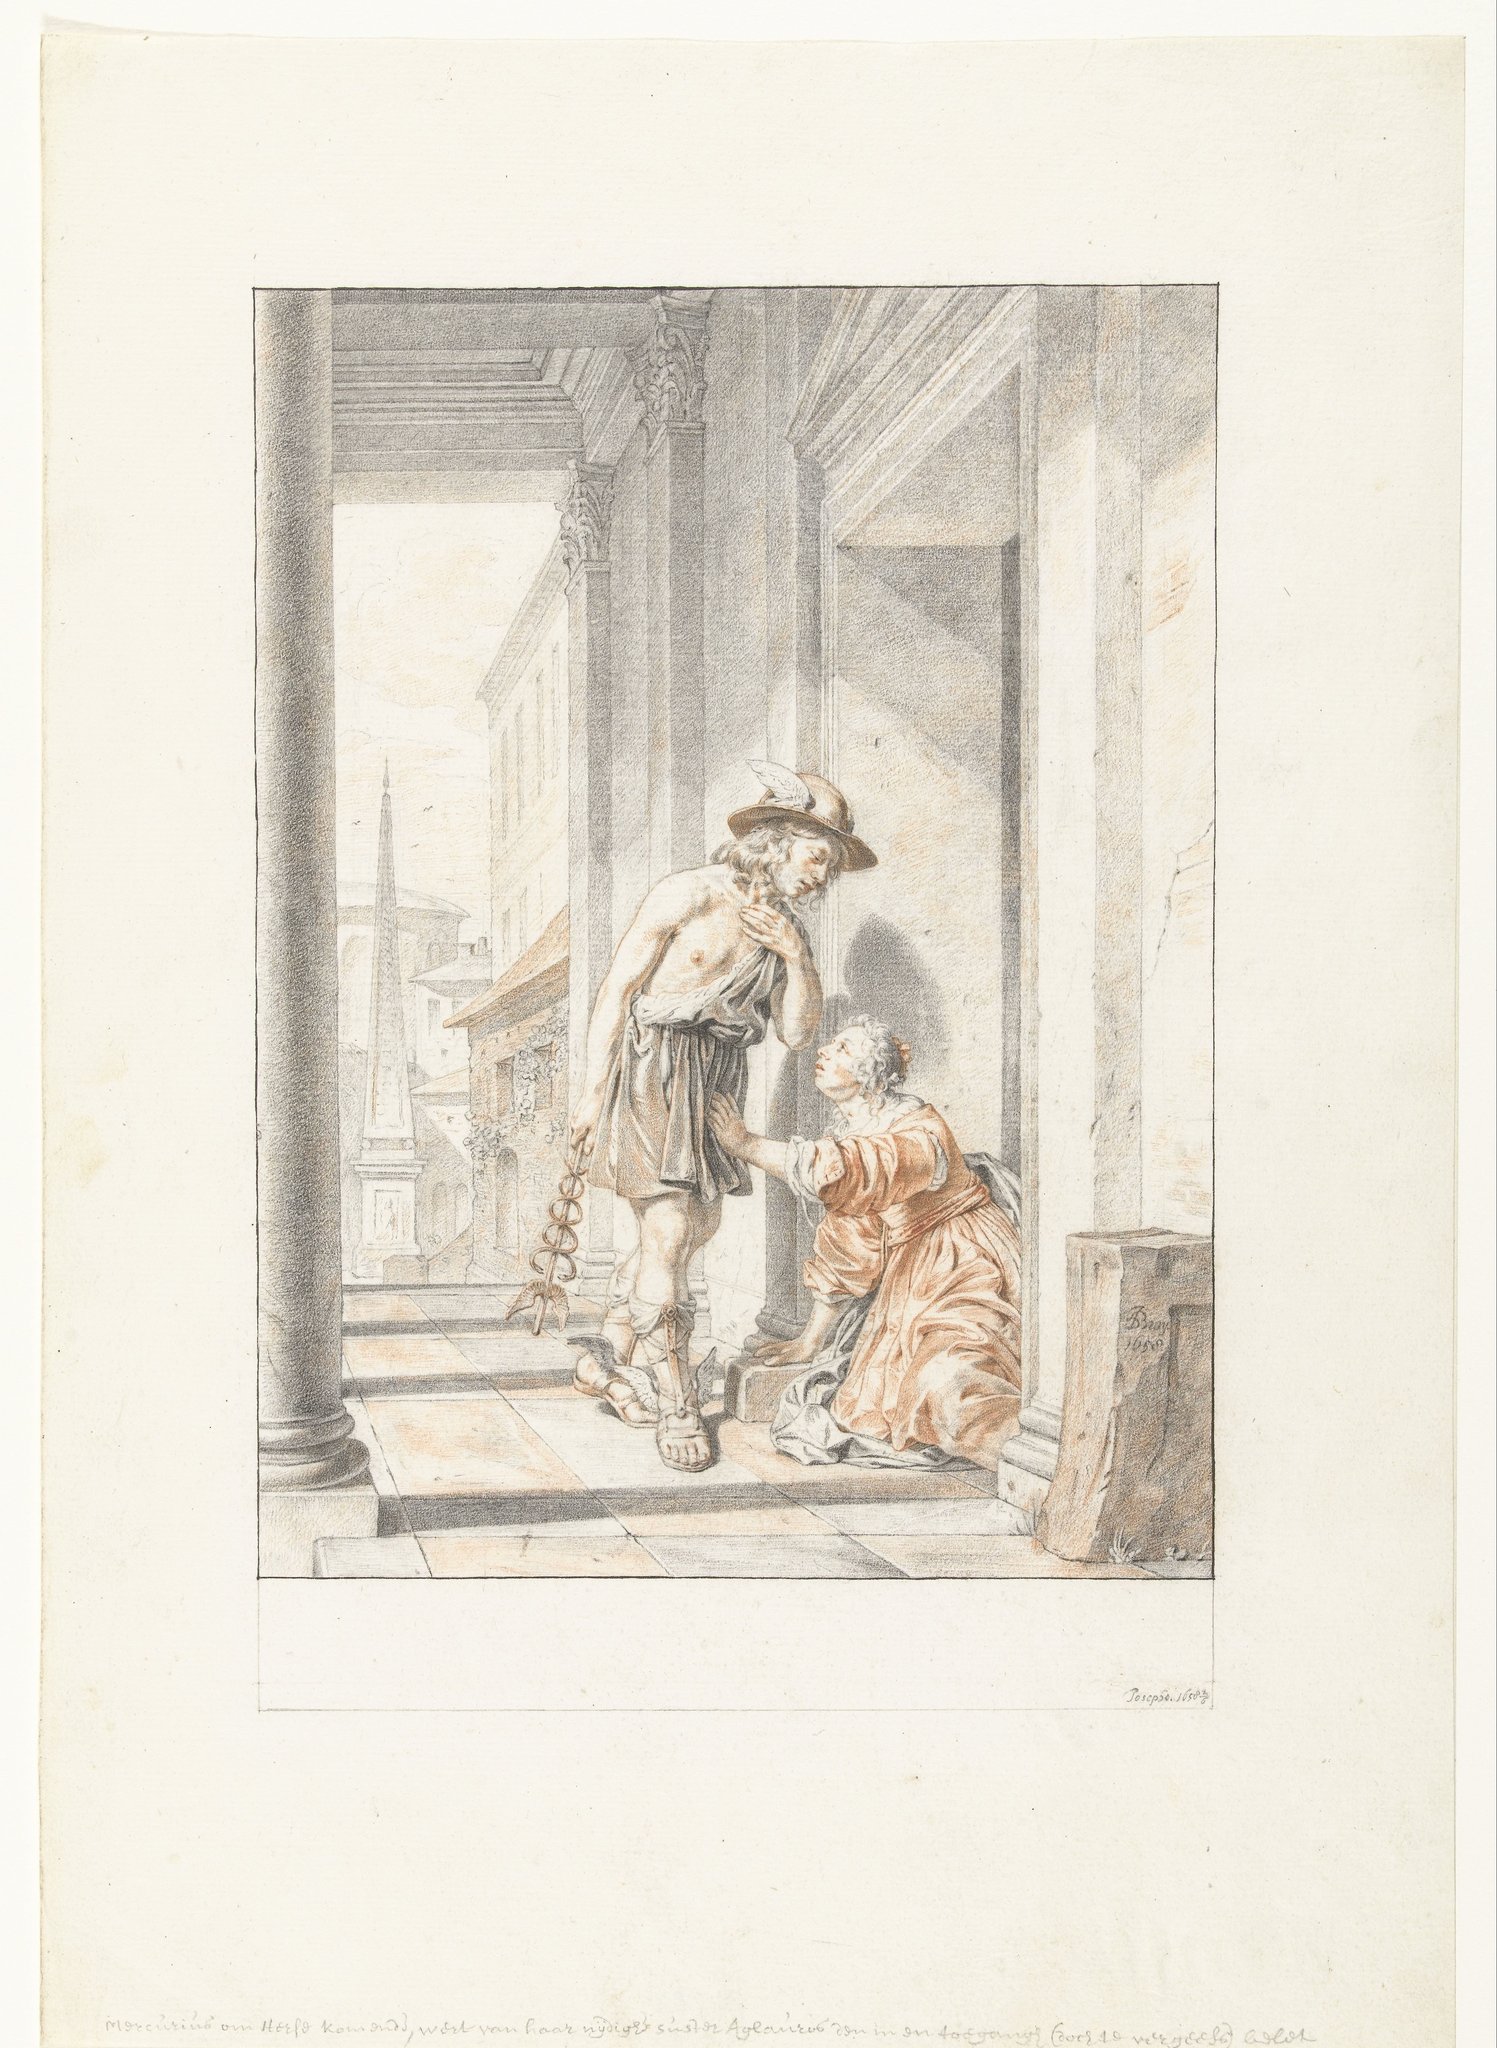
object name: drawing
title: Mercury and Aglauros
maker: joseph de bray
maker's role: draughtsman, painter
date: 1658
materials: chalk, paper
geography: haarlem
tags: (story of) mercury (hermes)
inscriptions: date: ‘Josepho 1658 2/6’